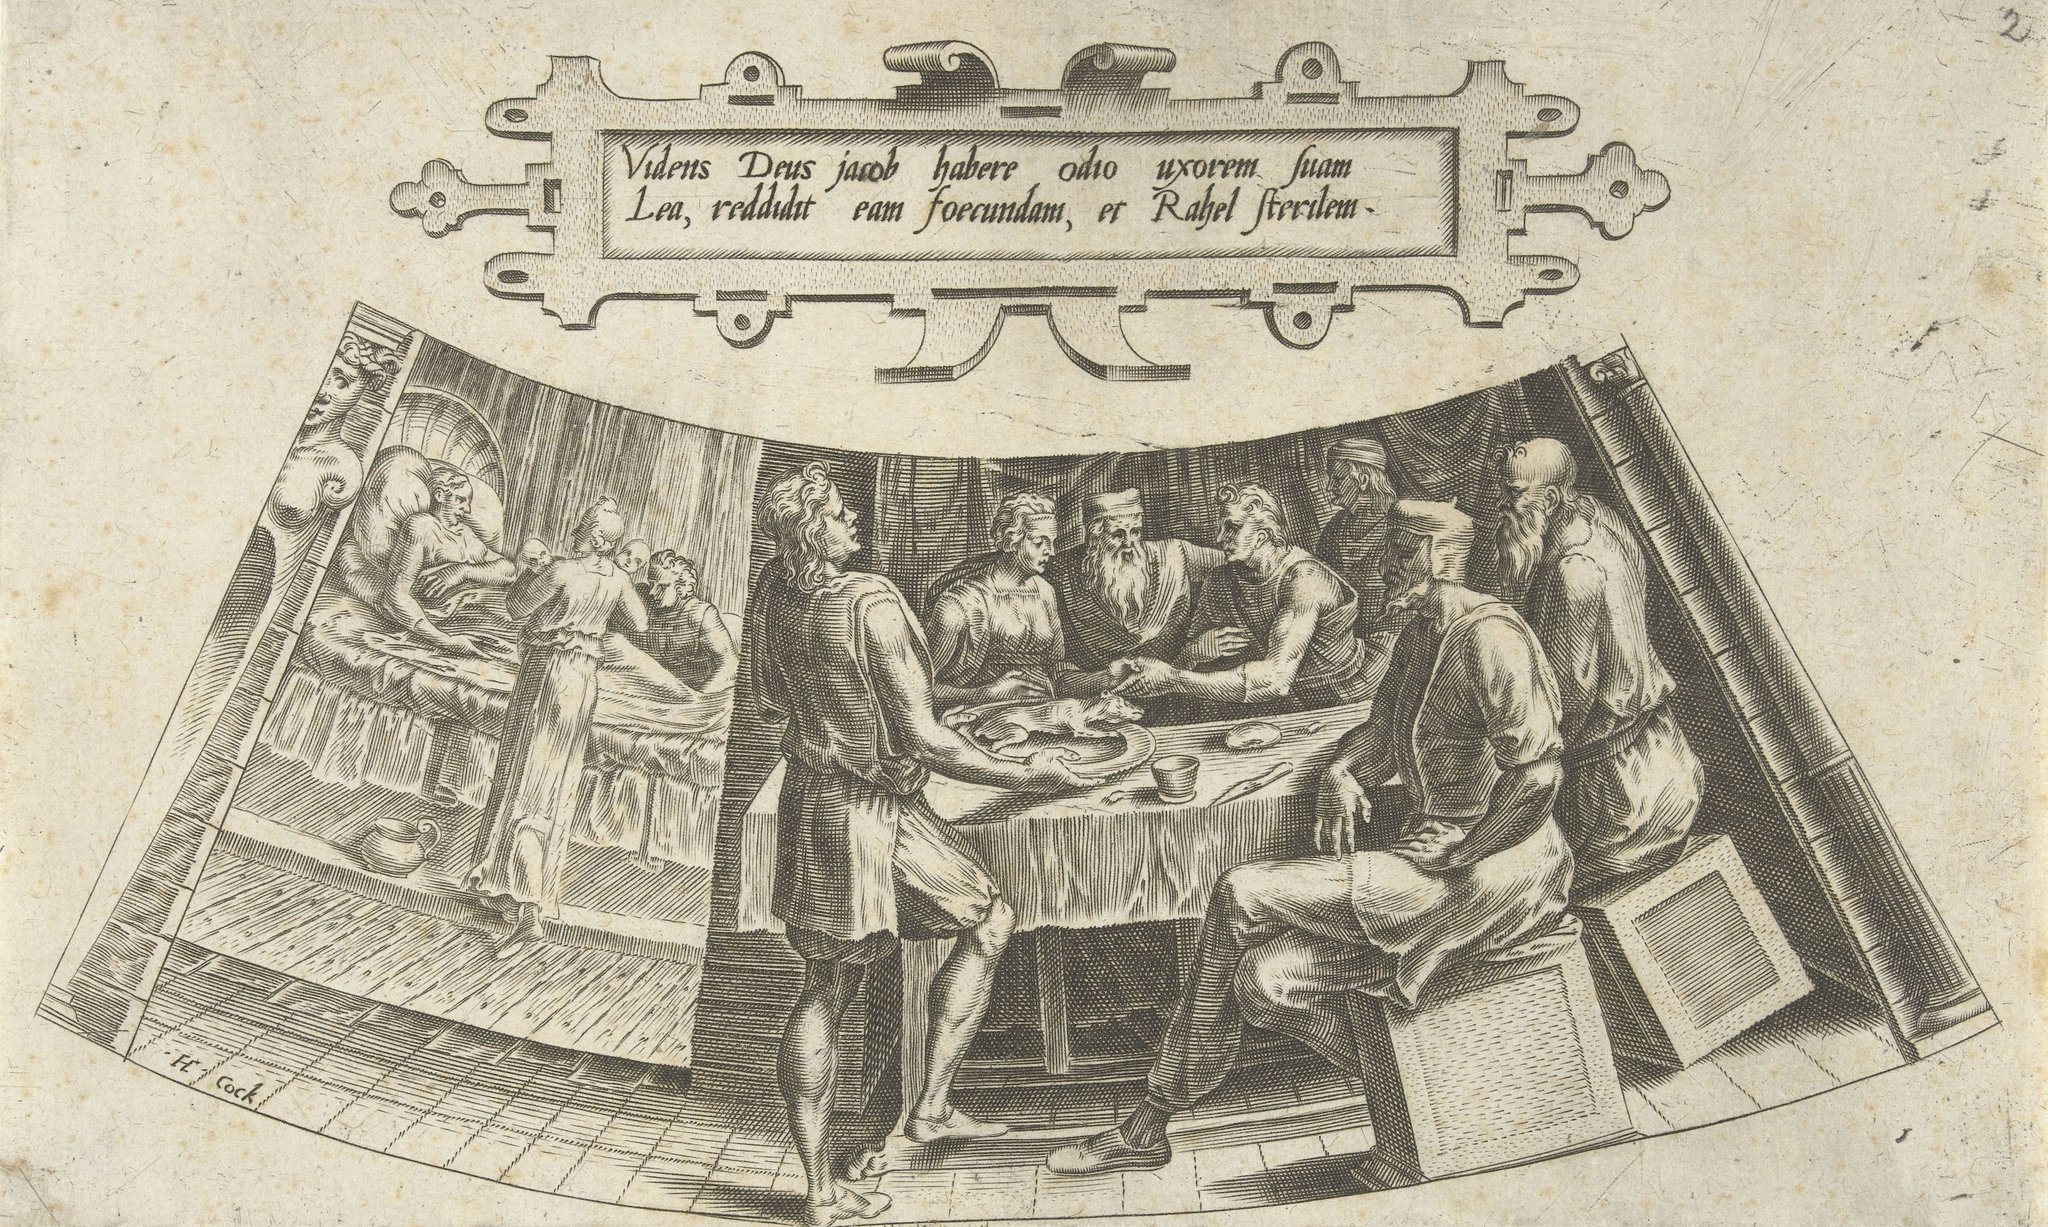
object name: print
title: De geschiedenis van Jacob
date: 1563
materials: paper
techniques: engraving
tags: ornament ~ cartouche, the marriage of jacob and rachel, leah bears four sons: reuben, simeon, levi and judah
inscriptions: collector's mark: Lugt 2228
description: Ornament voor schotelrand. Rechts de maaltijd voor het huwelijk van Jakob en Lea. Links een doorkijkje naar een slaapkamer met de geboorte van Lea's kind. Met Latijns bijschrift in cartouche.